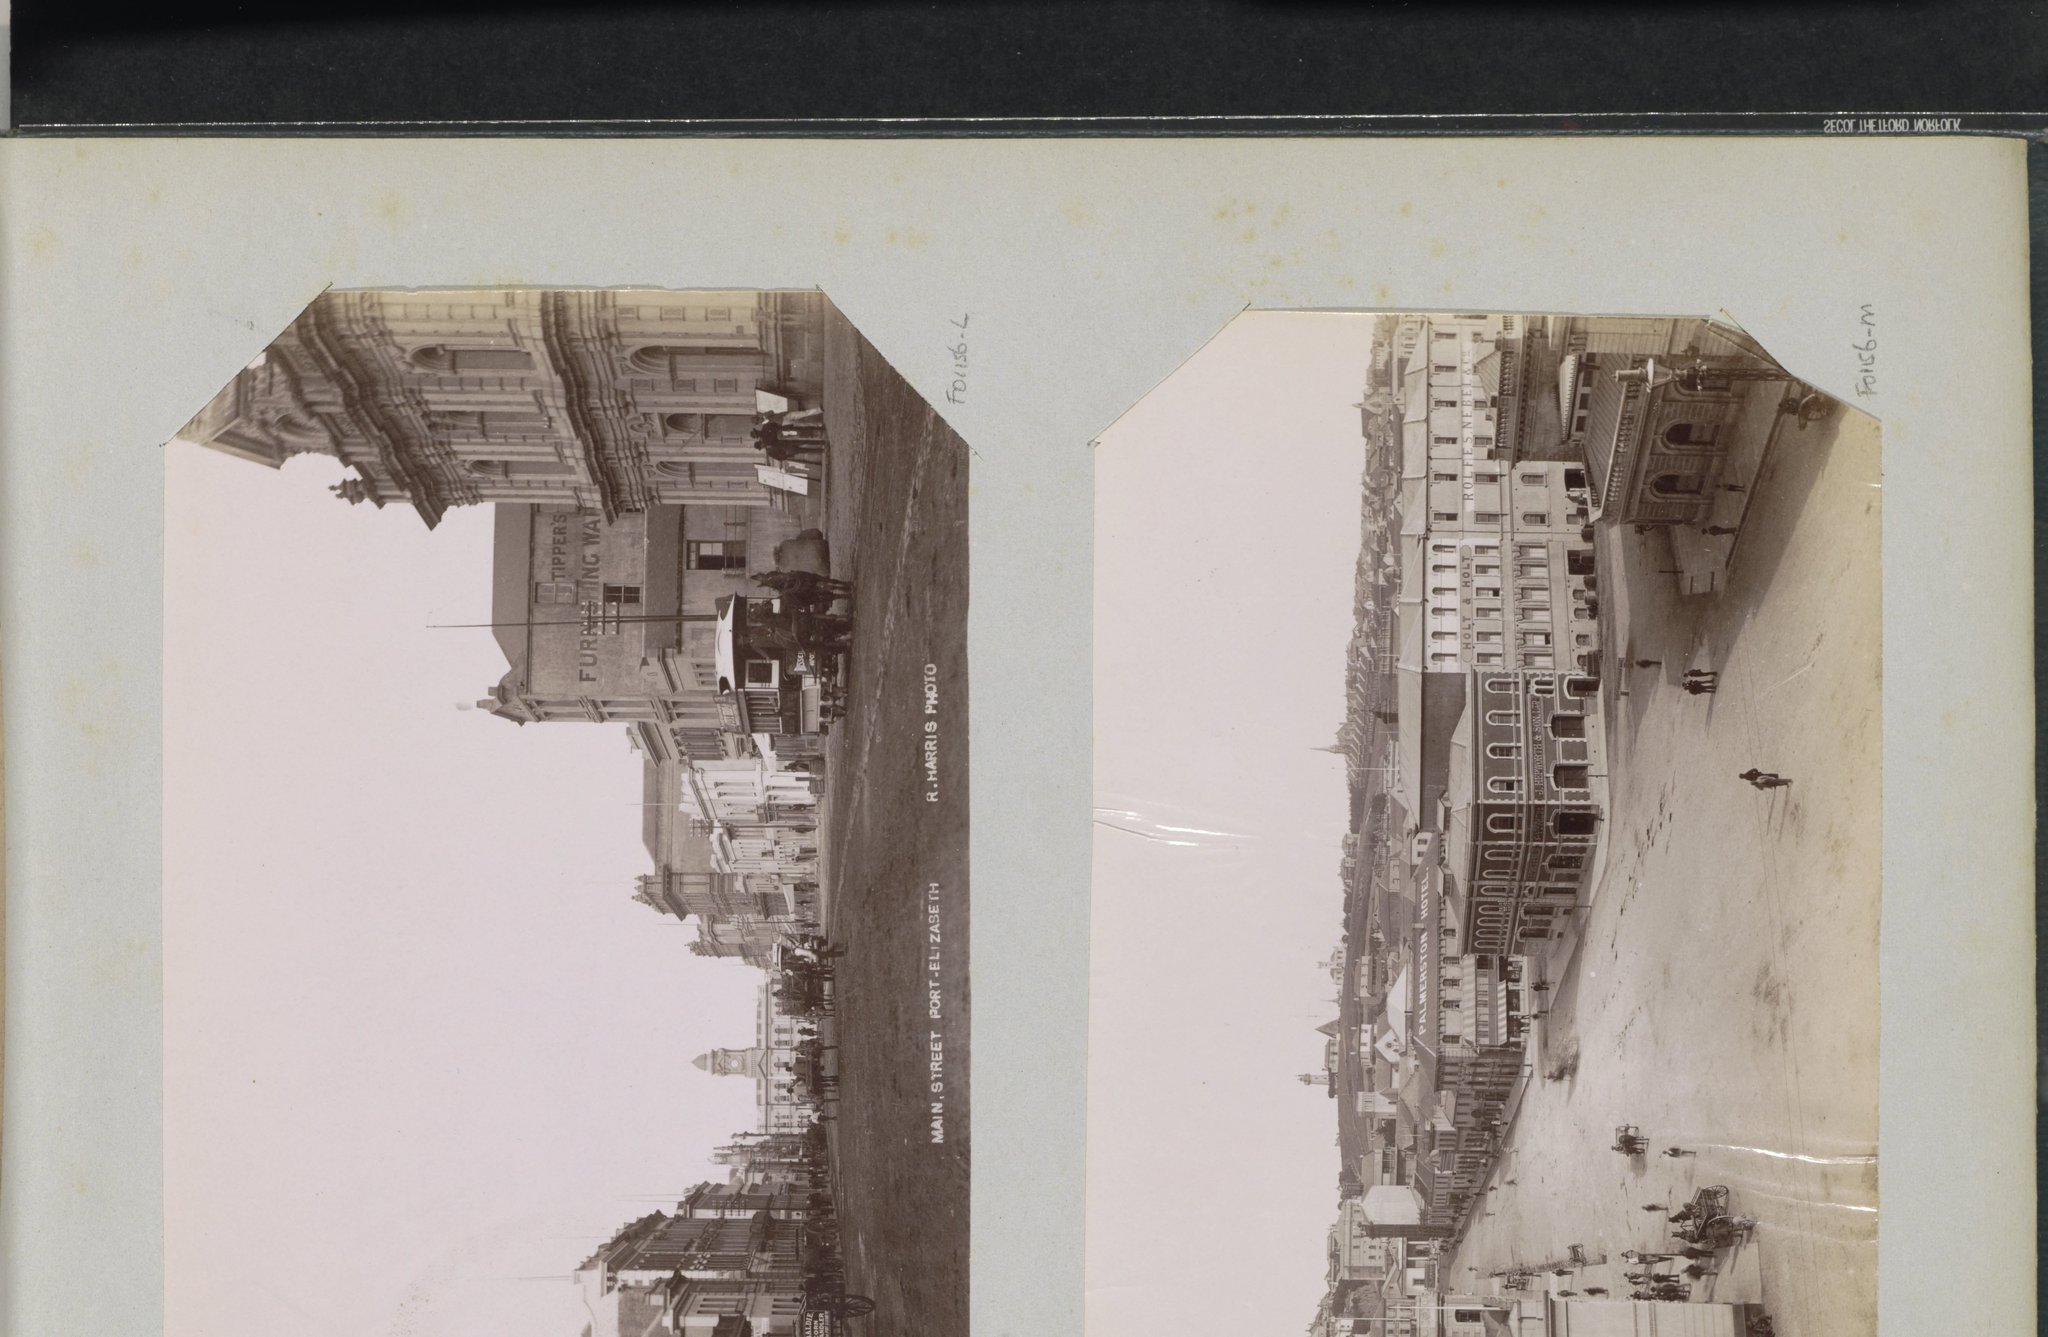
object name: photograph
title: Gezicht op Jettystreet te Port Elizabeth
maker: Anonymous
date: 1896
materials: photographic support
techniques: albumen print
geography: port elizabeth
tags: city-view in general; 'veduta', street (+ city(-scape) with figures, staffage)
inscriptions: annotation: ‘Port Elizabeth: Mainstreet - Jettystreet febr 8/17. April 8/20 1896’